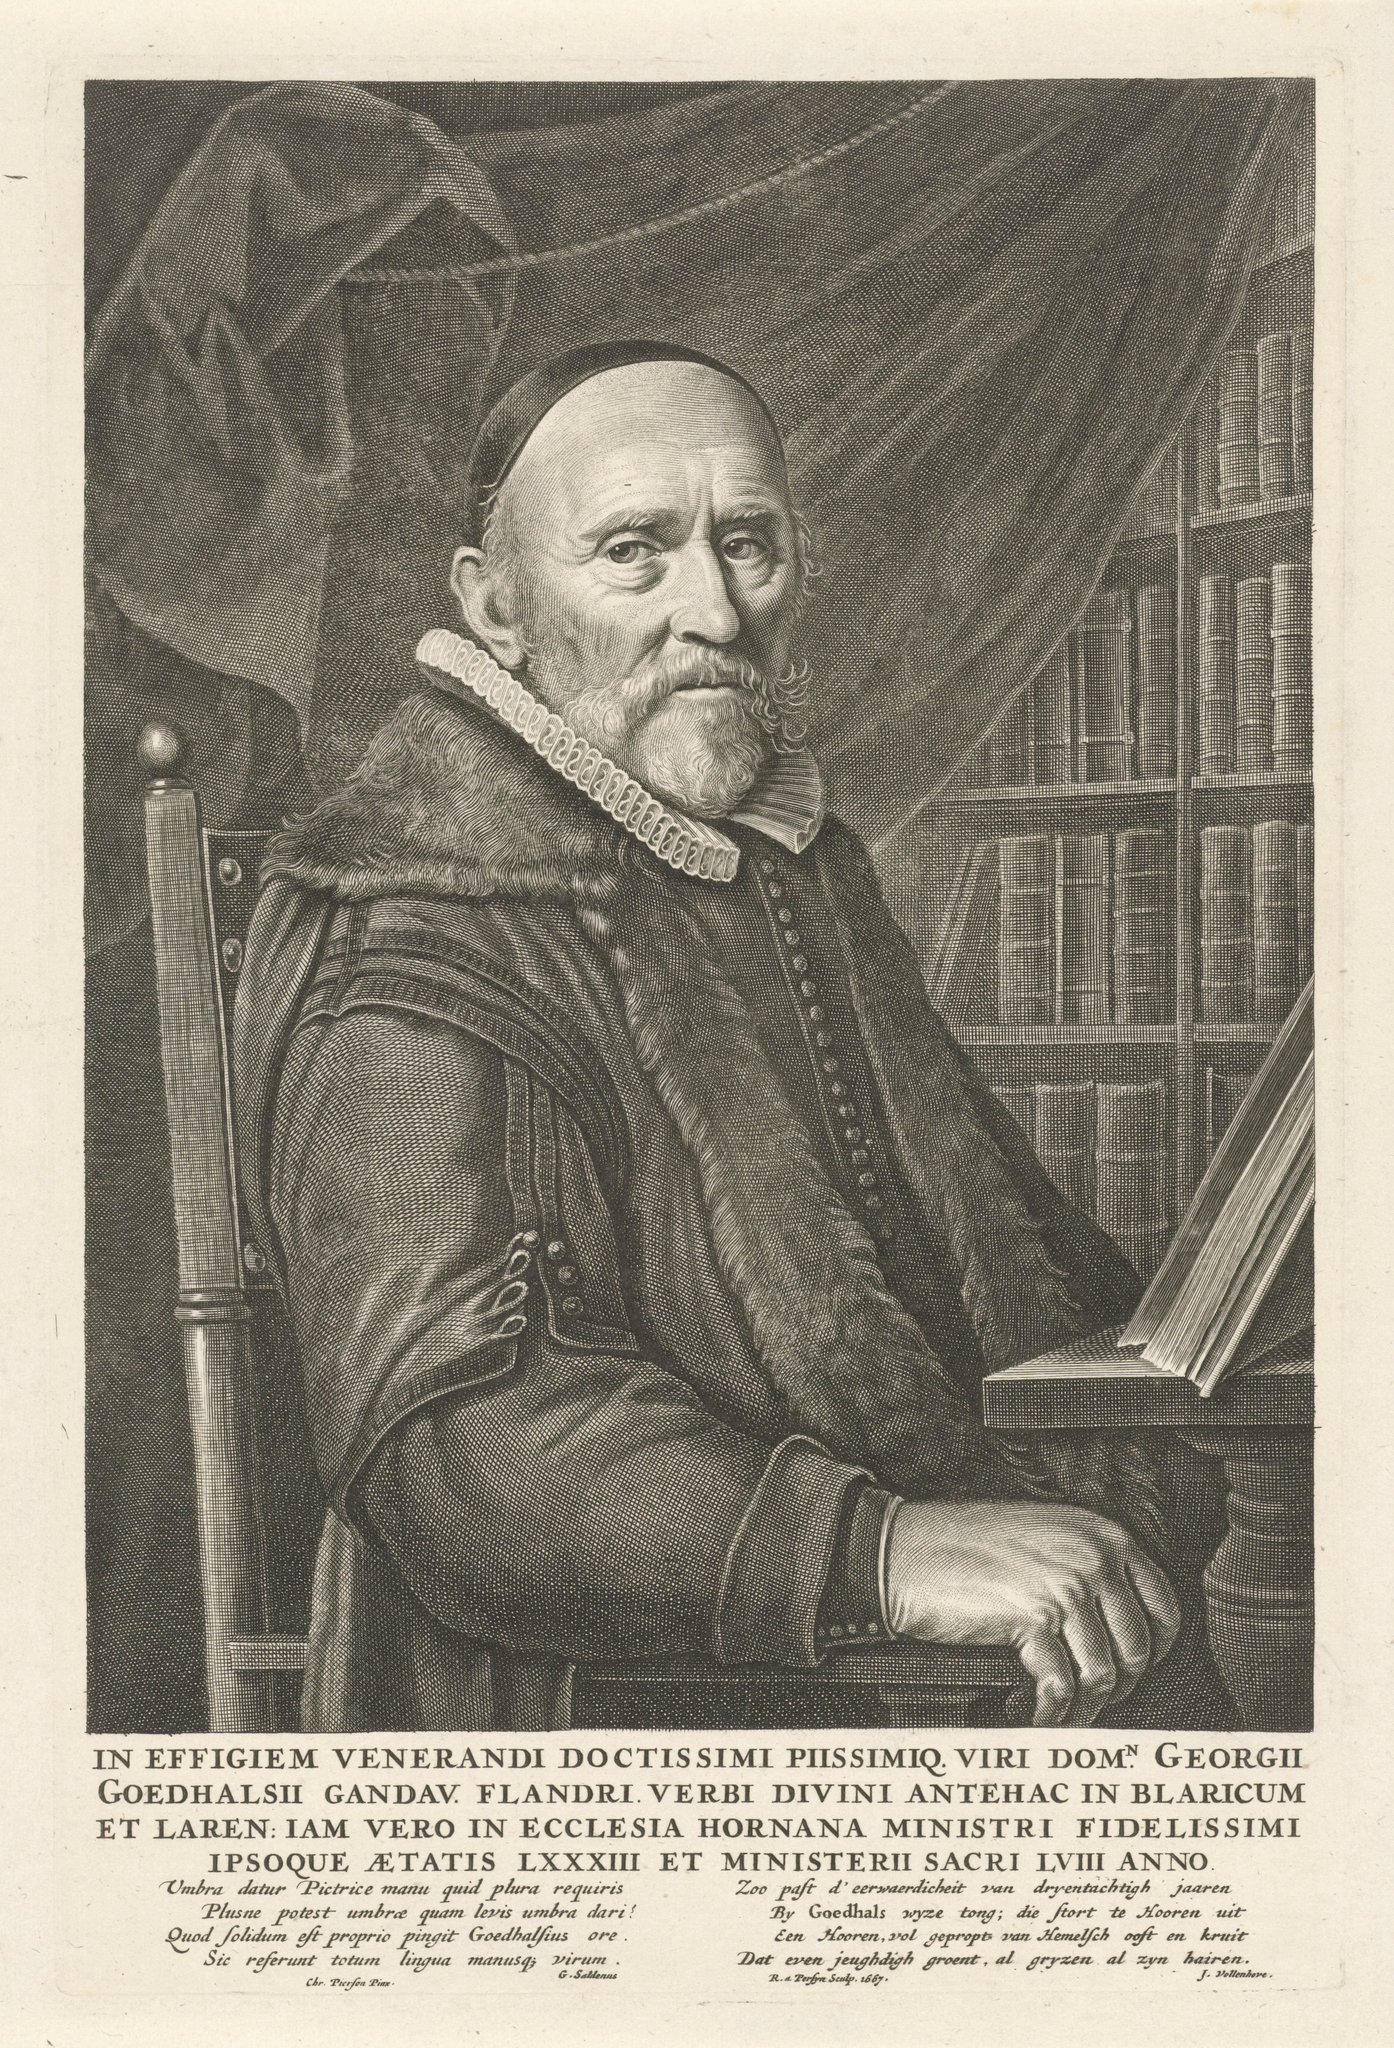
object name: print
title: Portret van George Goethals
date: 1667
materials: paper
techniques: engraving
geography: gouda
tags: study; 'studiolo'; library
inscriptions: collector's mark: Lugt 240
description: Portret van George Goethals, op 83-jarige leeftijd, predikant te Blaricum en Laren. In de marge een vierregelig onderschrift met de naam en functie van de geportretteerde in het Latijn. Daaronder een vierregelig lofdicht in het Latijn en in het Nederlands.